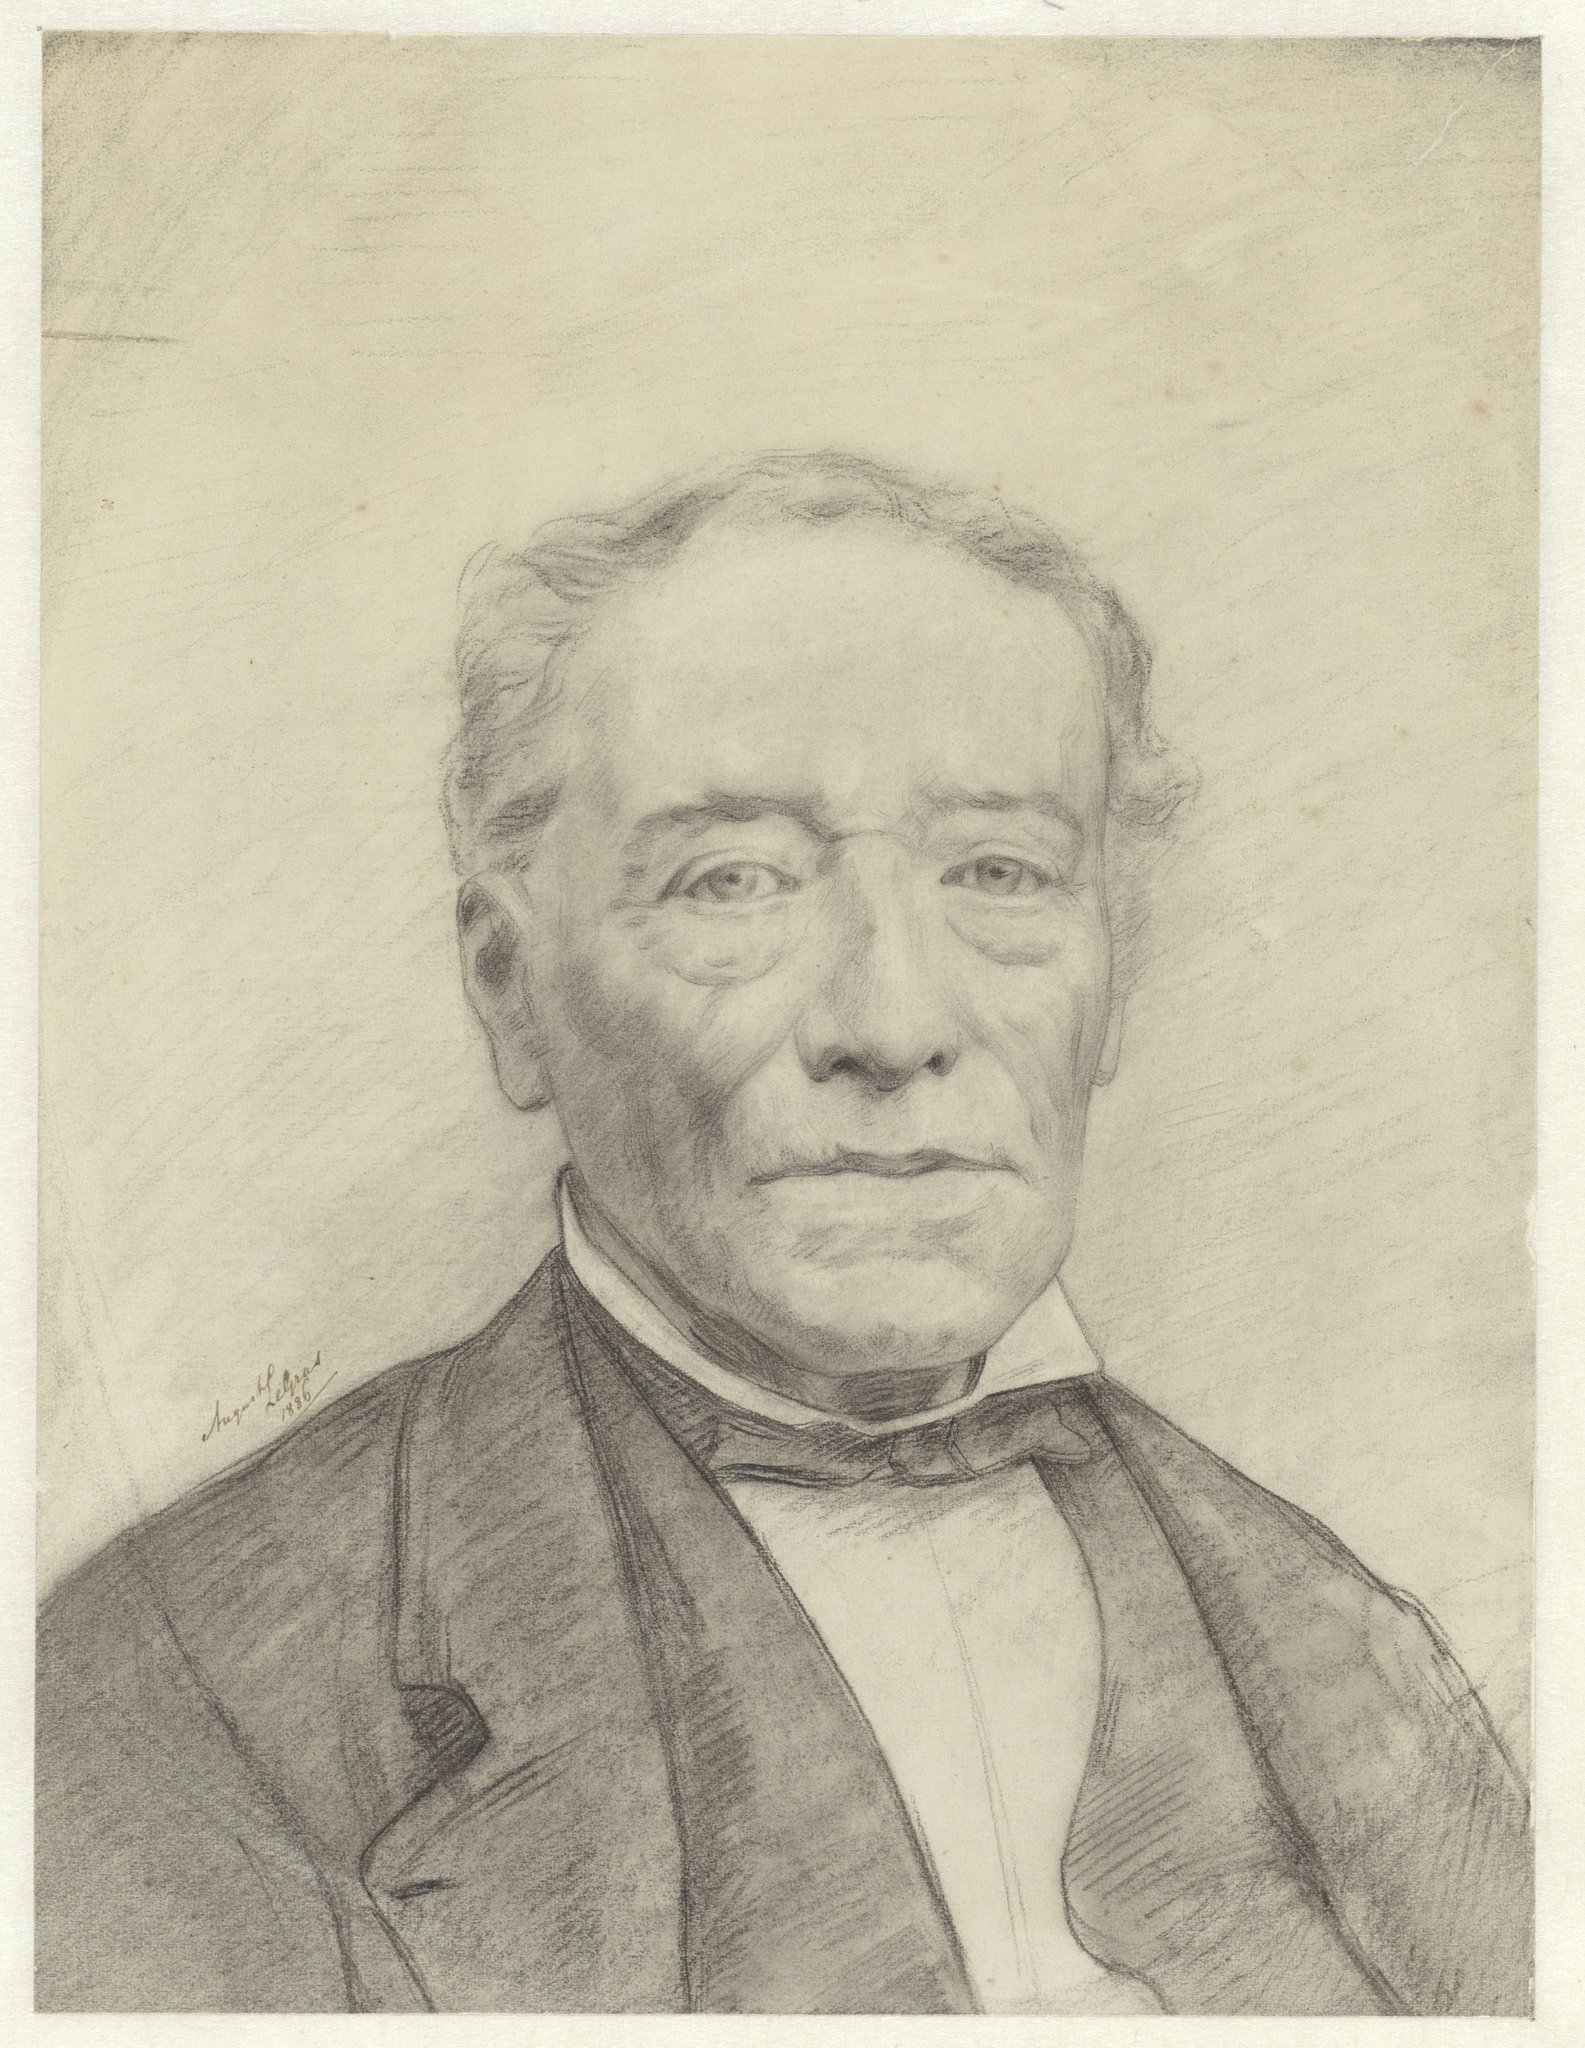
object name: drawing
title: Portret van een man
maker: august le gras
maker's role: draughtsman, print maker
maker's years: 1864-1915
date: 1886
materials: chalk, paper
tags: anonymous historical person portrayed alone